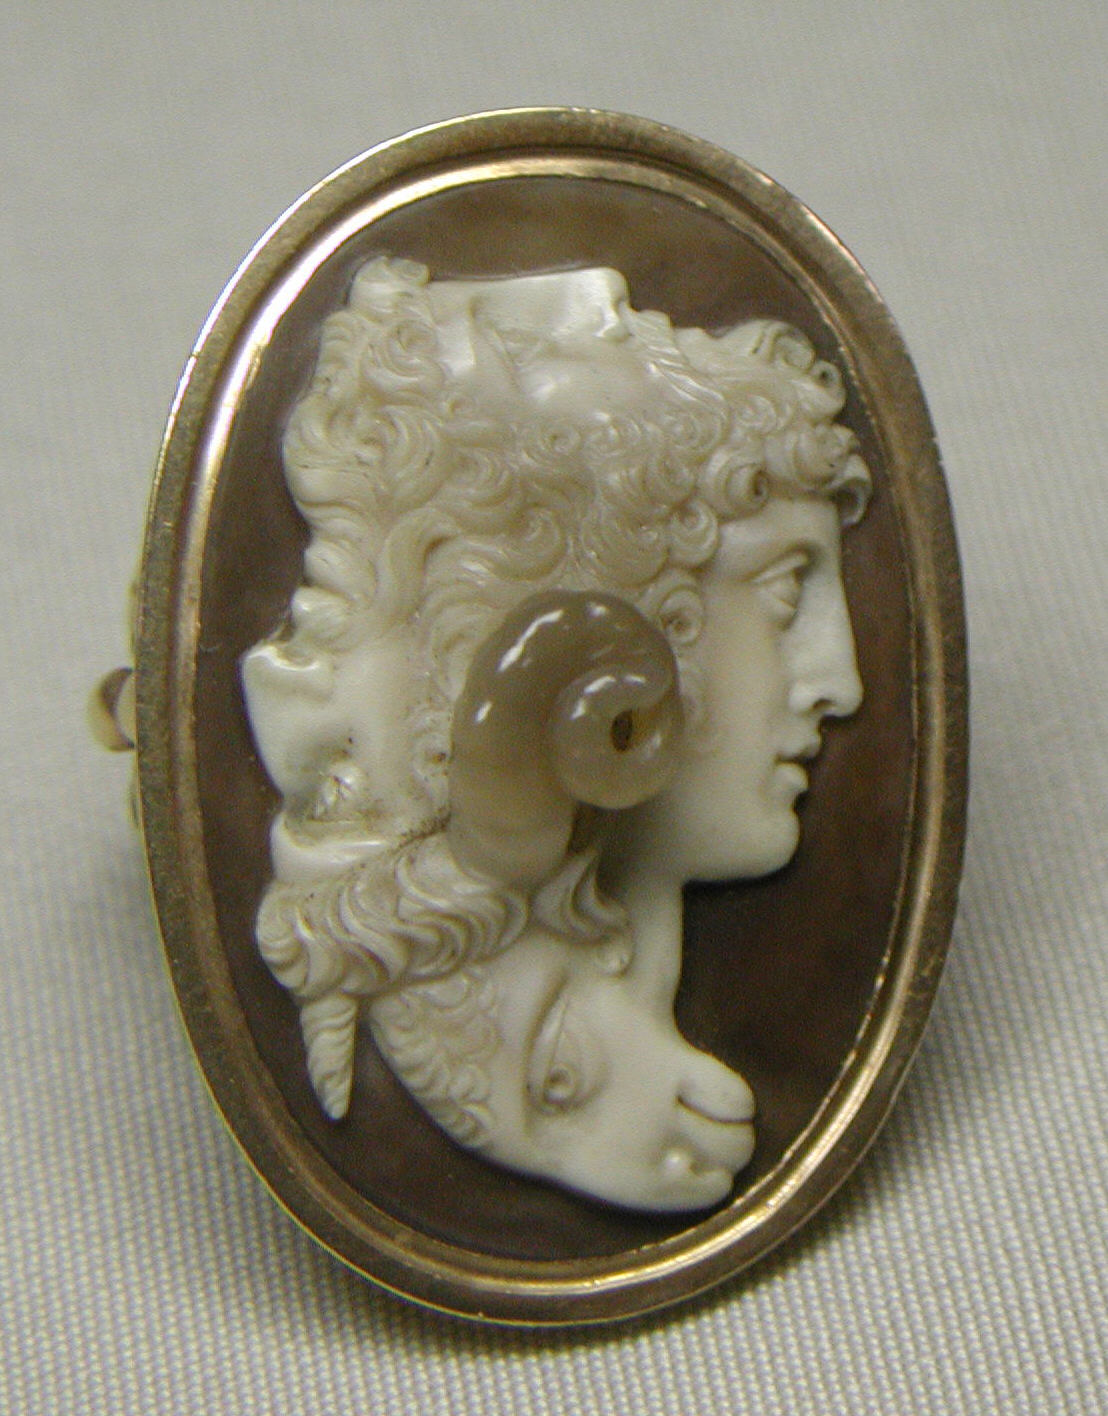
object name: cameo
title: Gryllos: conjoined heads of a youth, a bearded man, a satyr, and a ram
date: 1767-1833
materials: gold, onyx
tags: heads,men,satyrs,rams